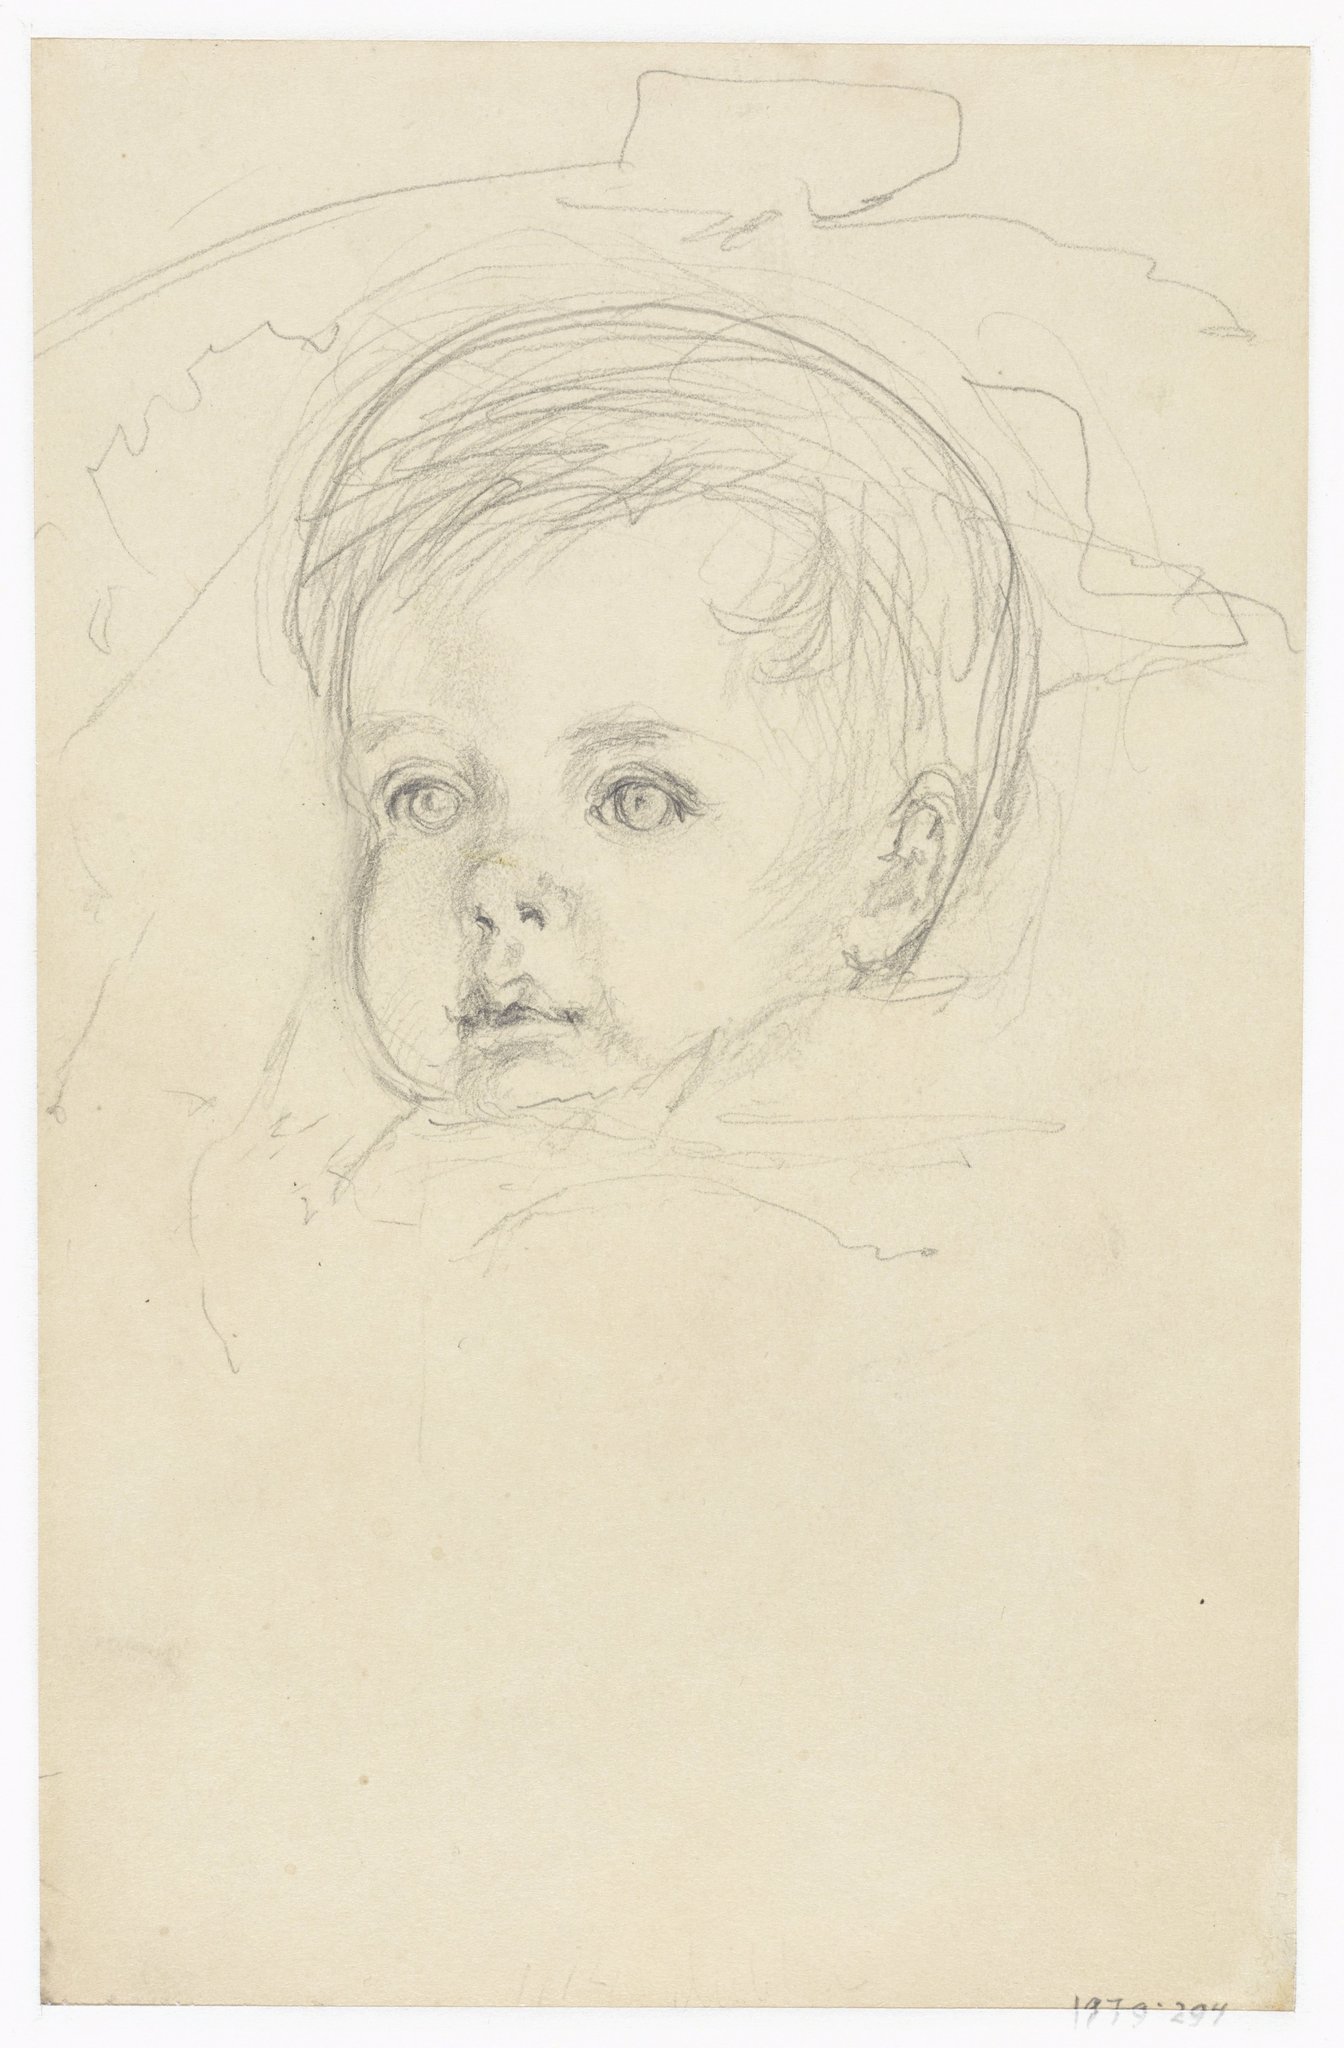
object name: drawing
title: Kinderportret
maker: jozef israëls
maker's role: draughtsman, painter, print maker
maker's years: 1824-1911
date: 1834-1911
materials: paper, pencil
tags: anonymous historical person portrayed alone